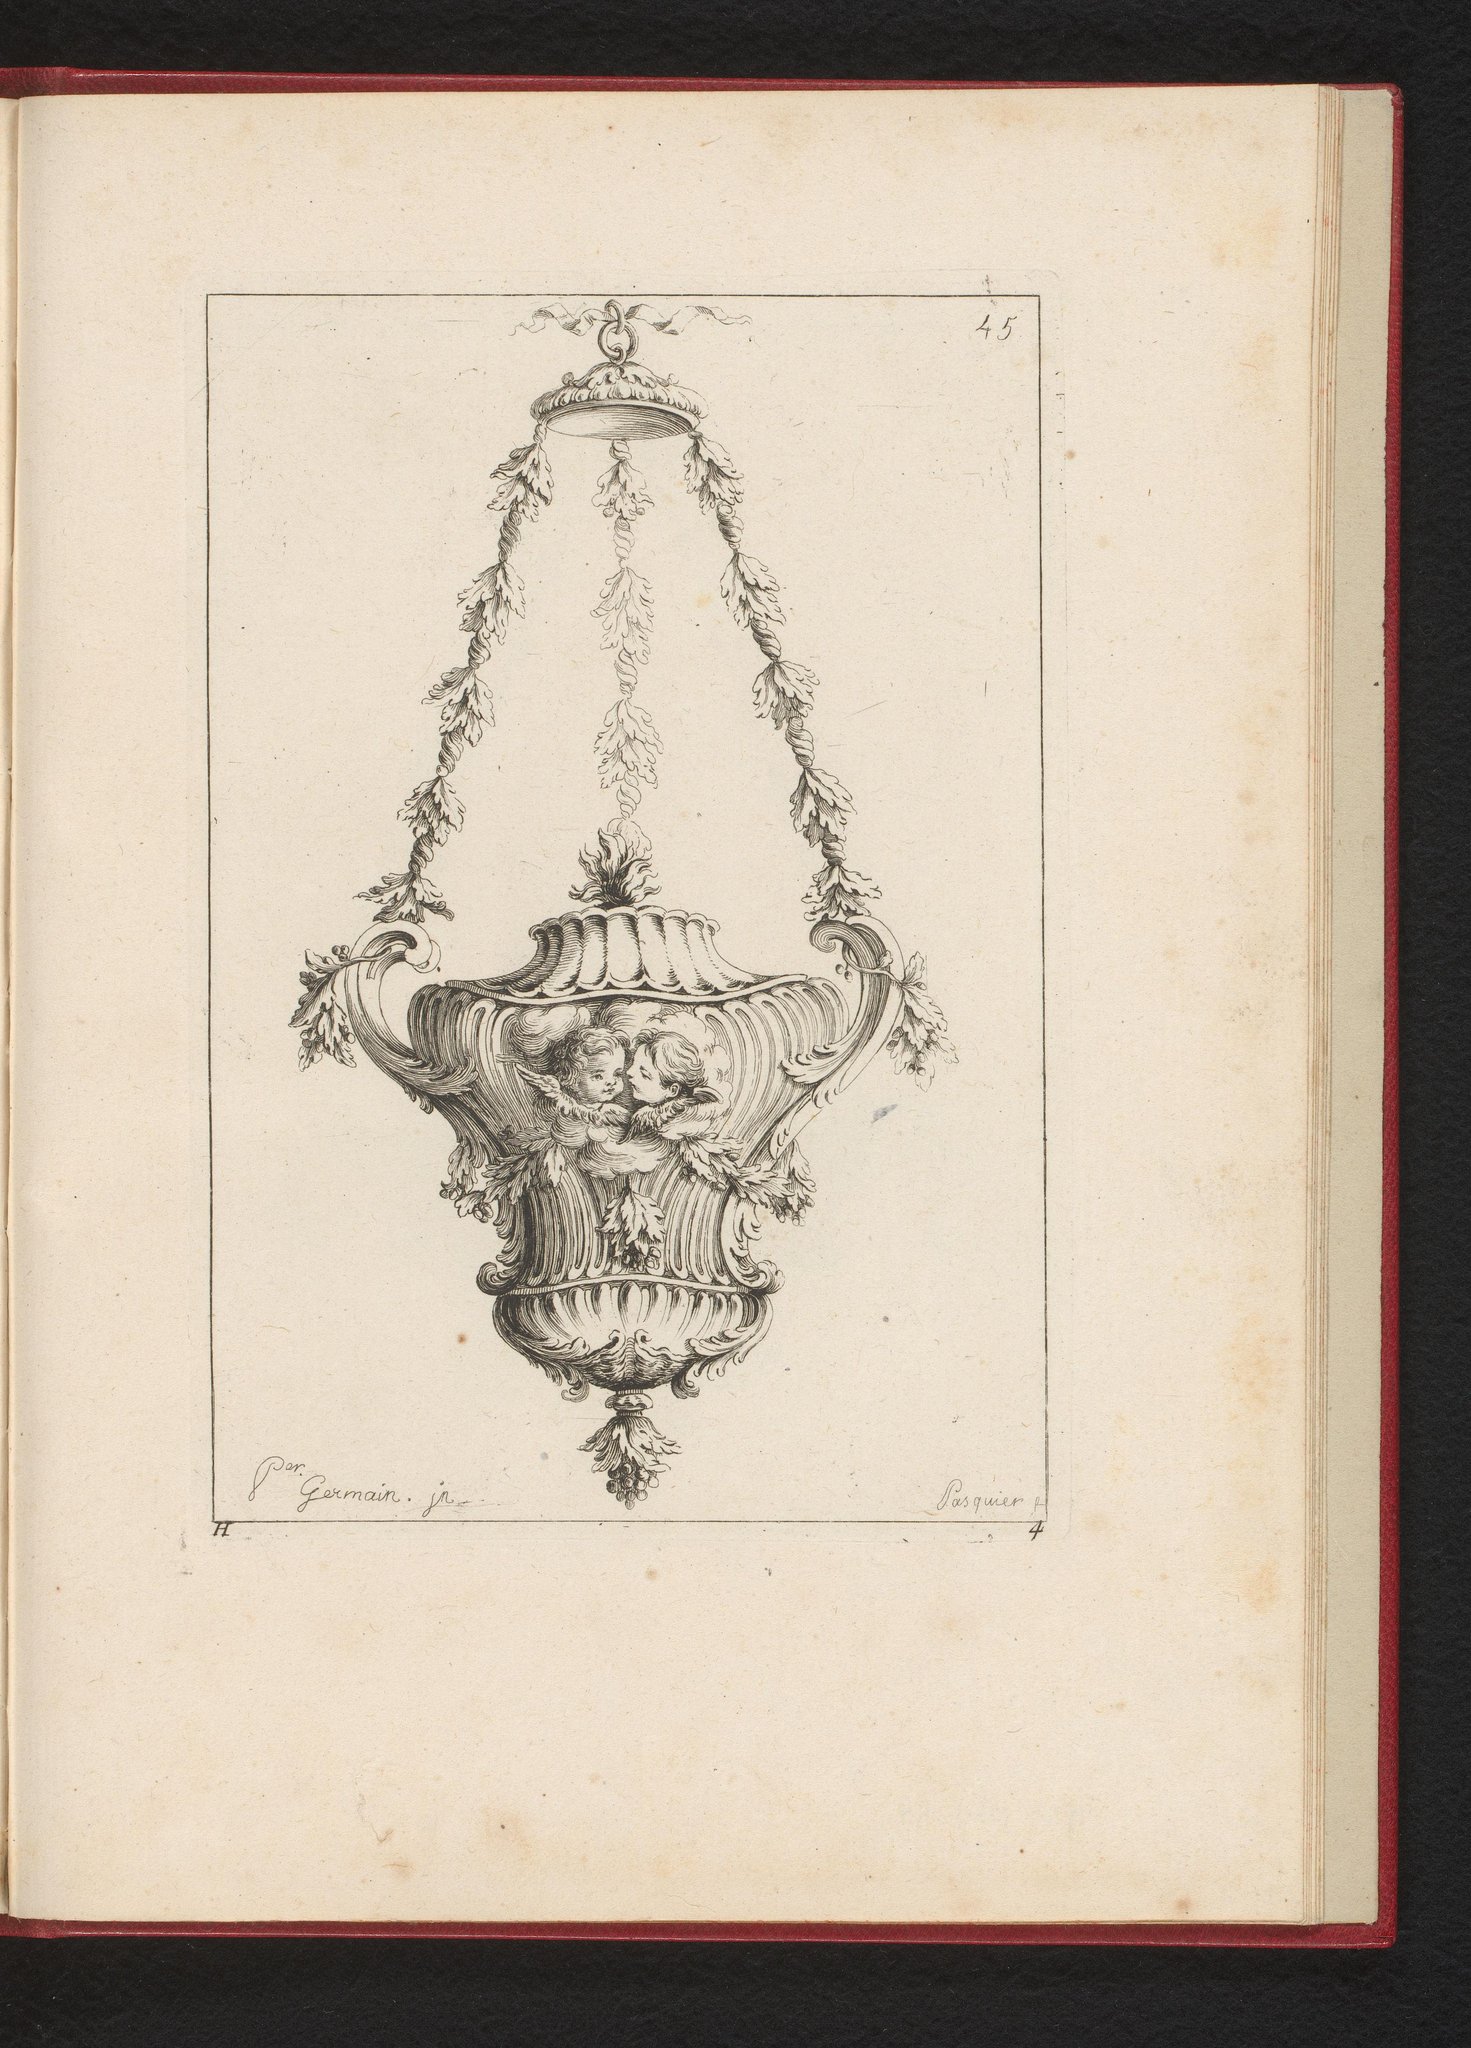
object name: print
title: Zilverwerk en edelsmeedkunst, eerste deel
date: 1748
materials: paper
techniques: etching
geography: paris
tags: altarlamp, altar fire, jeweller, goldsmith, silversmith, oil-lamp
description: Deze prent maakt deel uit van een album.